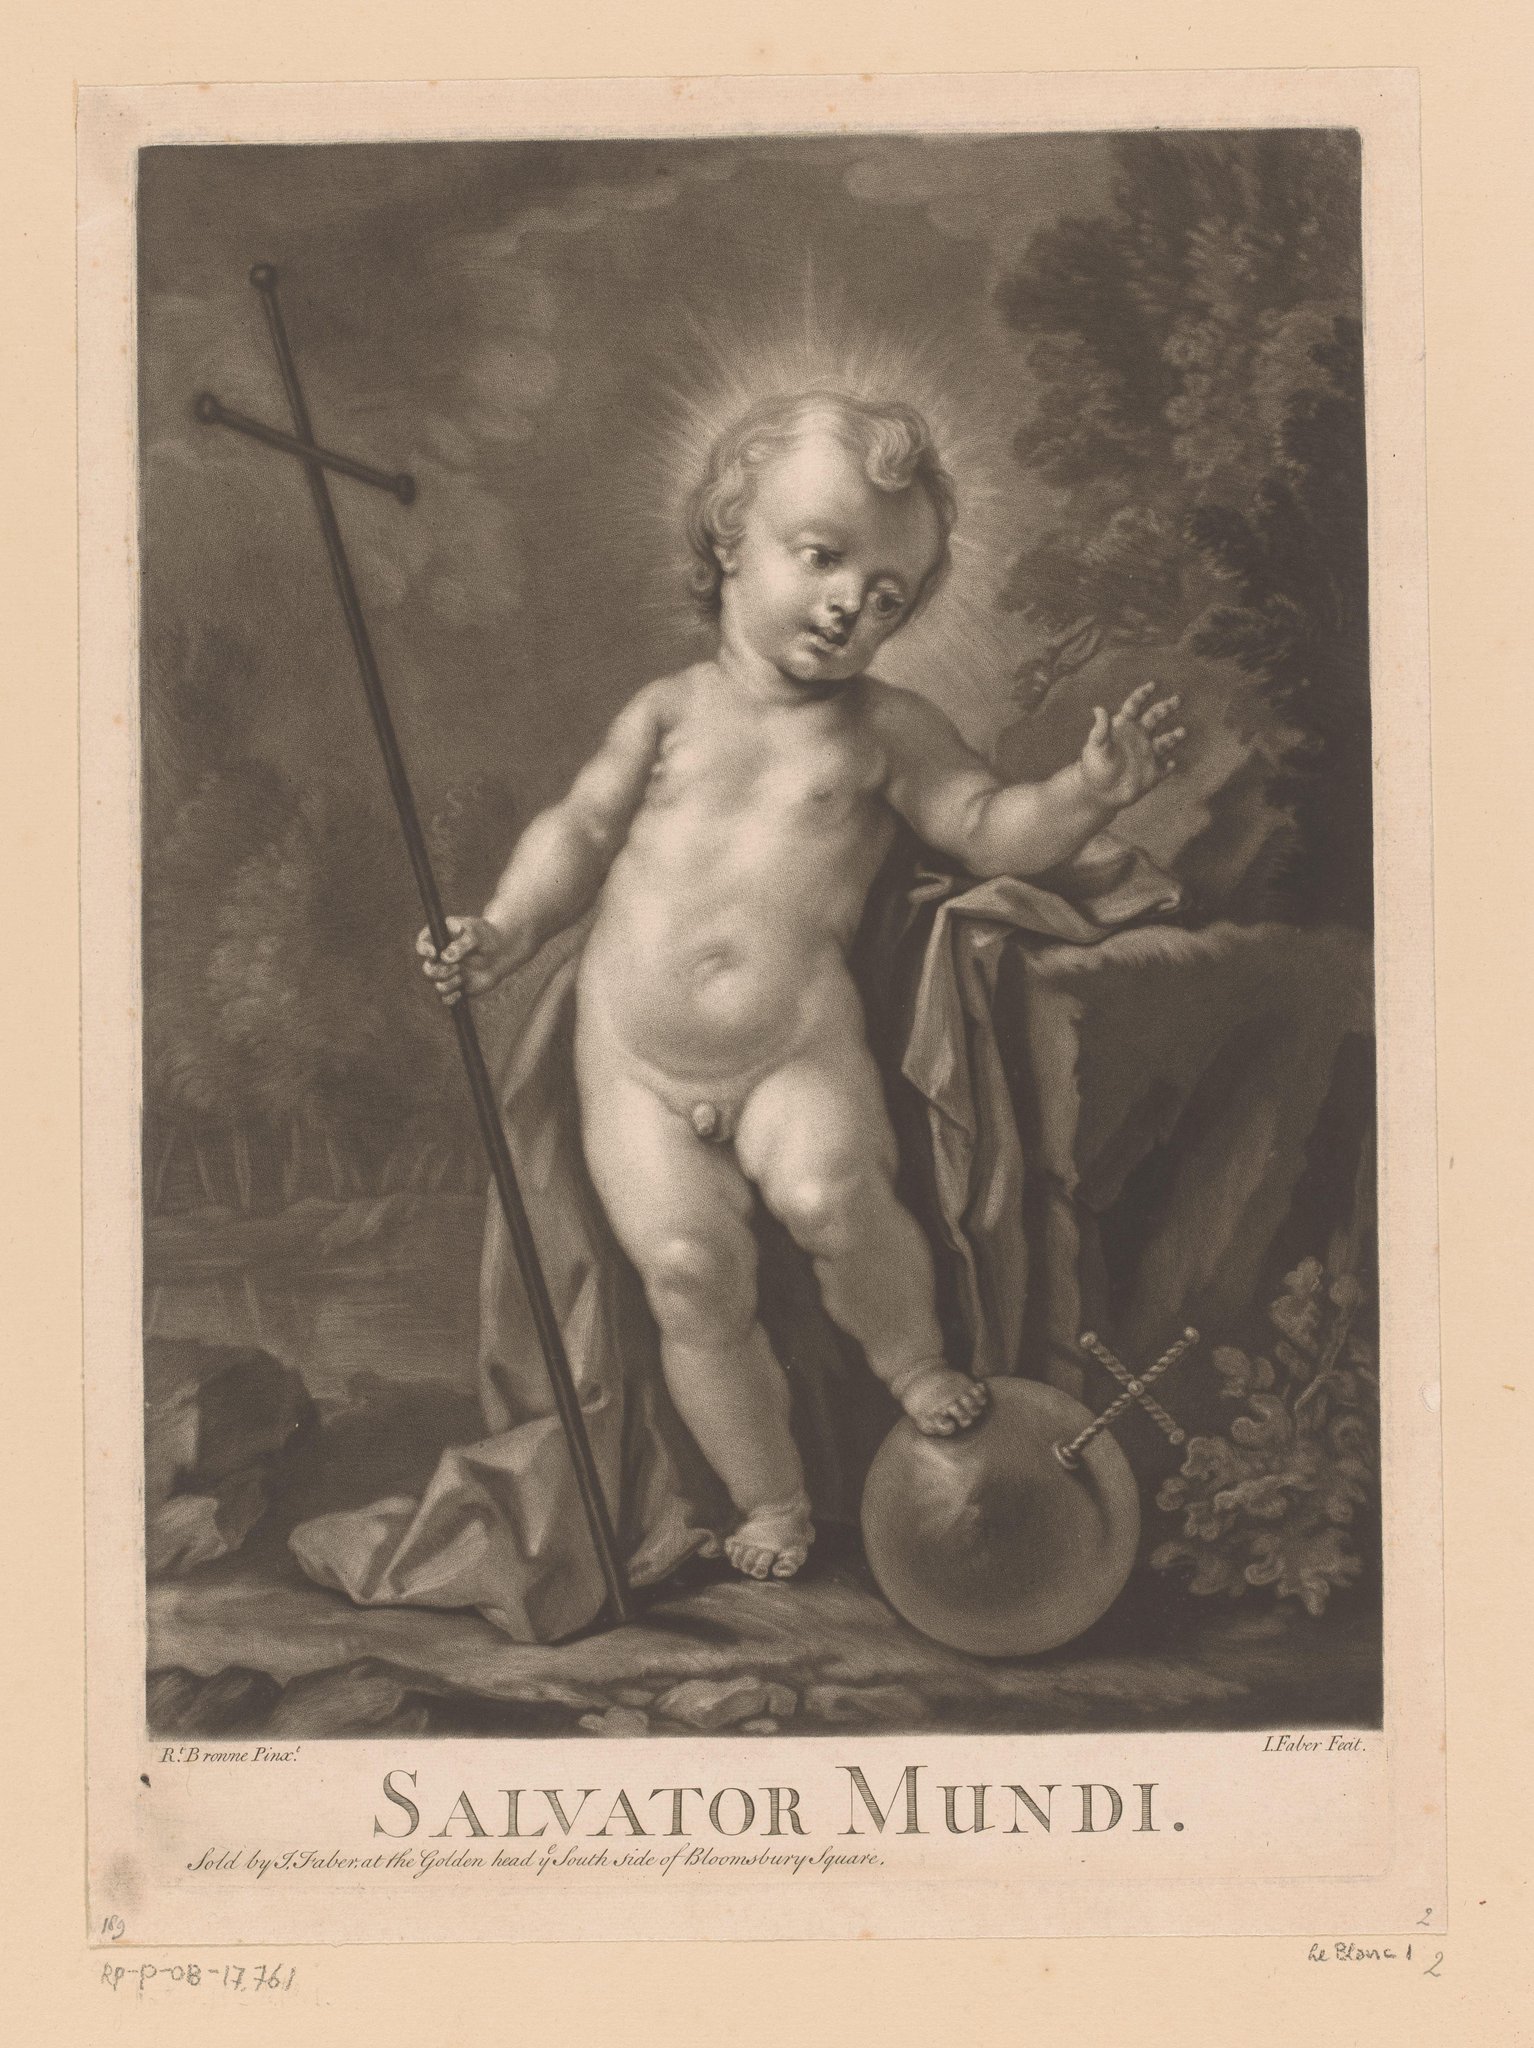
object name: print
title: Salvator Mundi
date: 1694-1756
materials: paper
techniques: etching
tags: christ-child (with attributes), 'salvator mundi', making a blessing gesture; an orb in his hand or at his feet - dd - christ beardless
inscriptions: collector's mark: Lugt 240